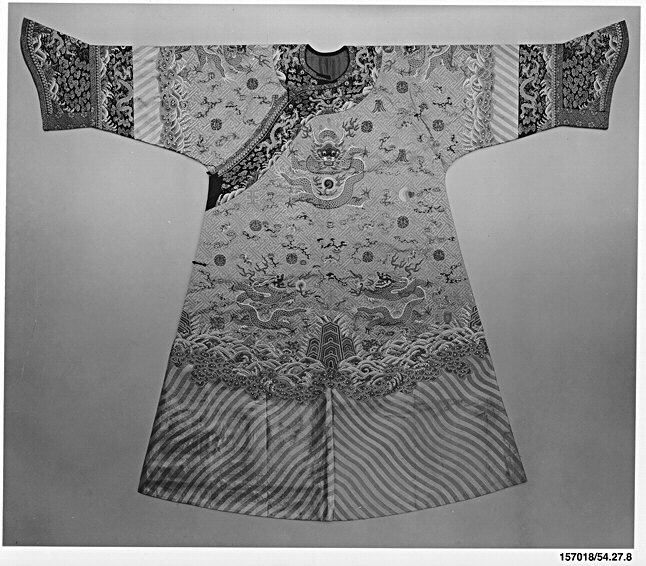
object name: robe, emperor's 12 symbol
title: Empress's Twelve-Symbol Robe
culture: chinese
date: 1821-1850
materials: silk, thread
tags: dragons